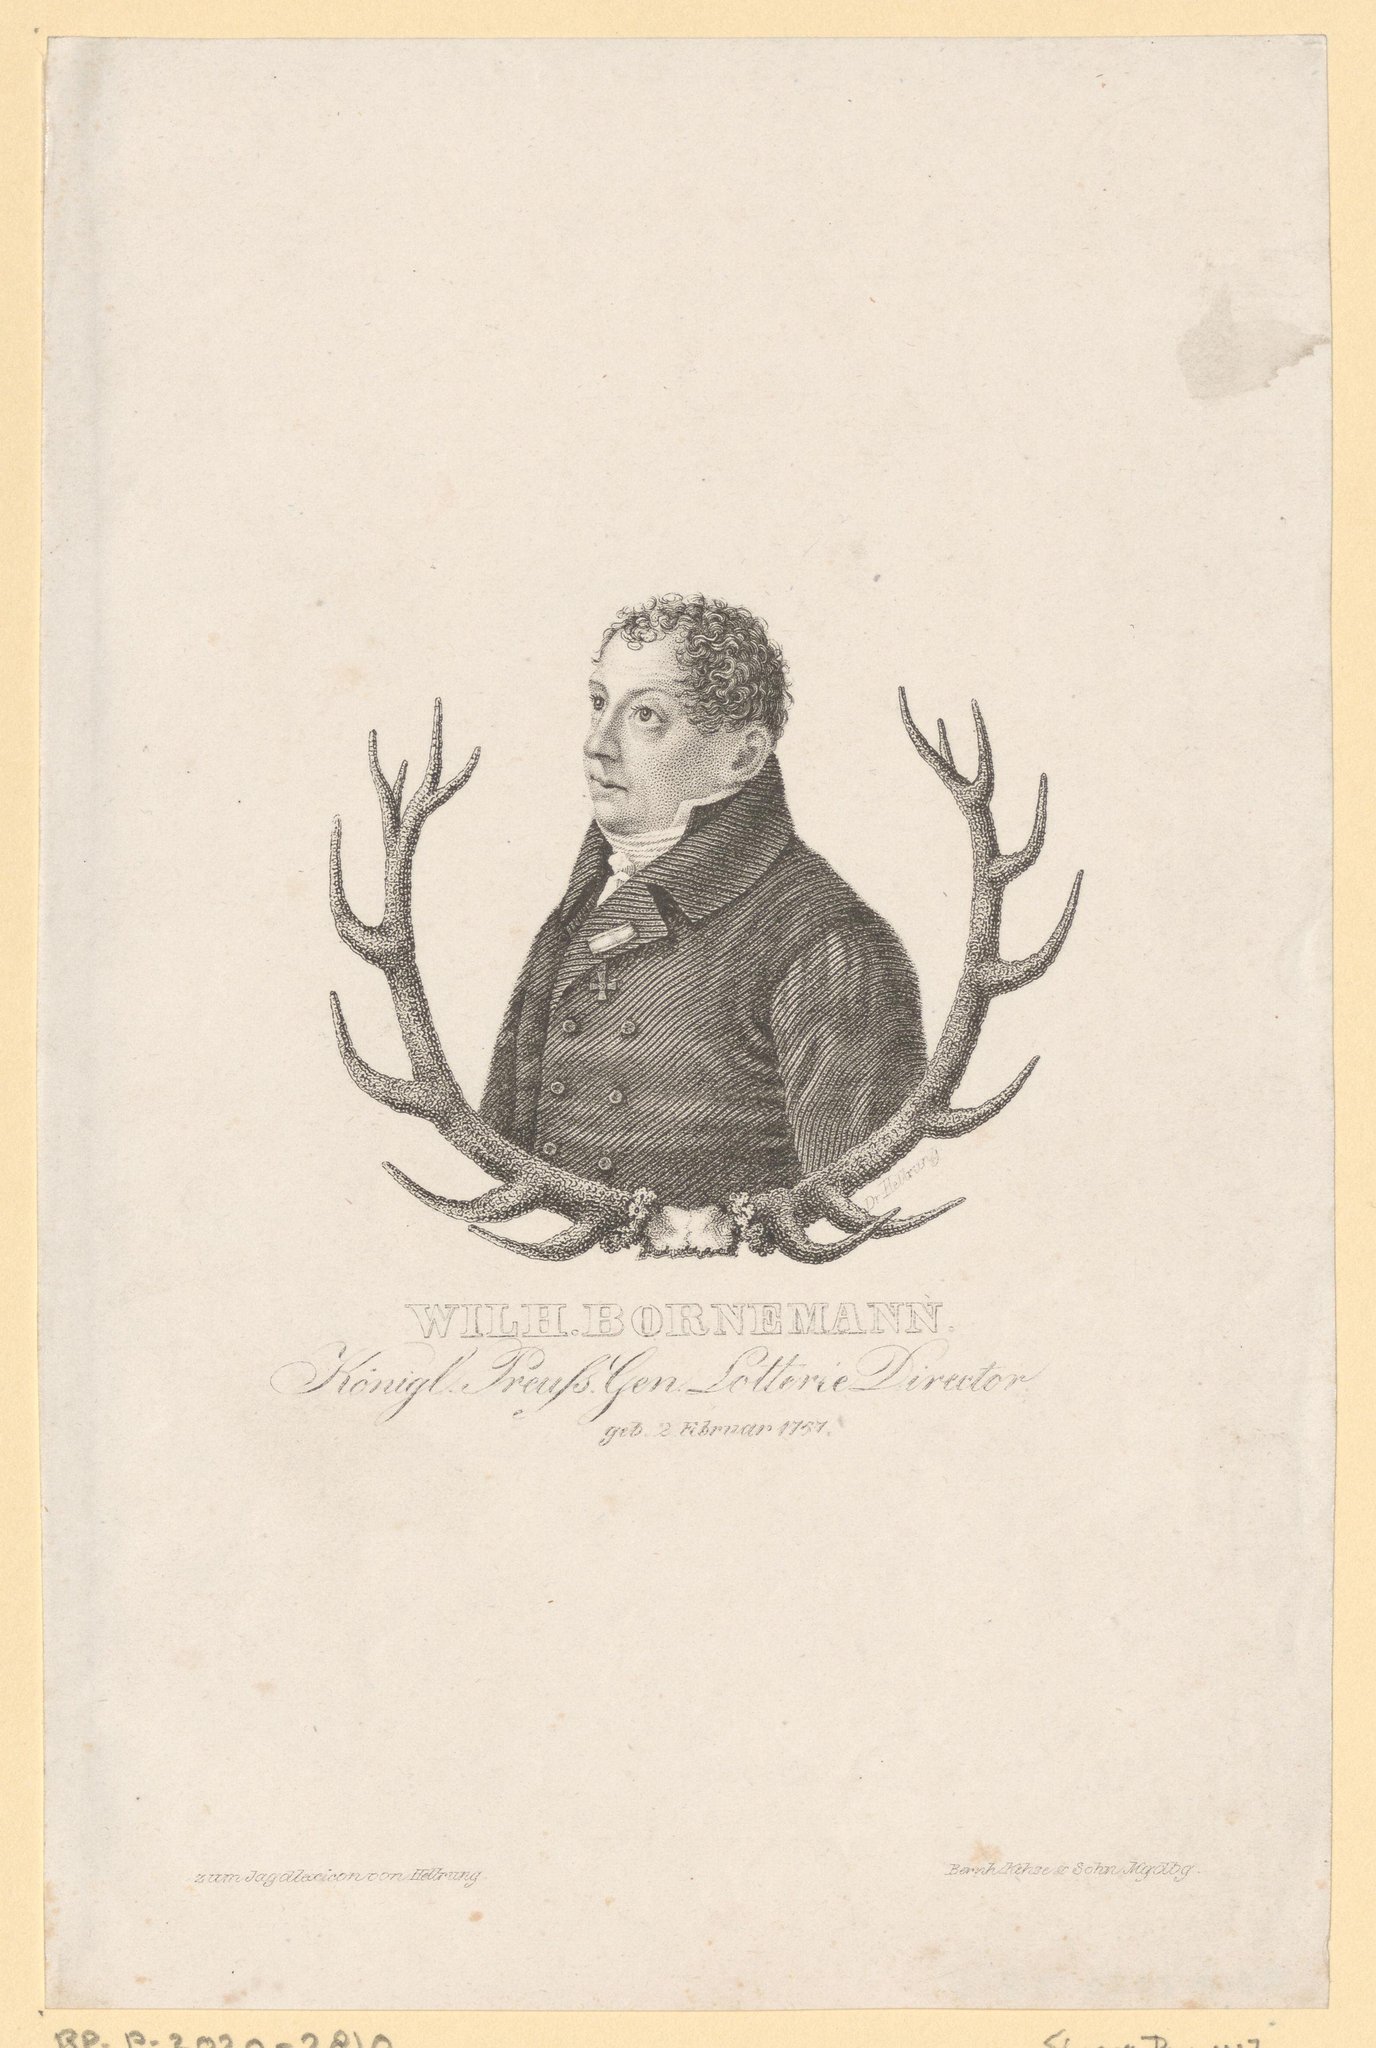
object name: book illustration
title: Portret van Wilhelm Bornemann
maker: carl ludwig hellrung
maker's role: draughtsman, print maker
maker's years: 1794-1851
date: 1839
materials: paper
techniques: lithograph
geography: magdeburg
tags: historical persons, hunting trophies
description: Prent waarschijnlijk uit: Hellrung, Carl Ludwig. Conversations-lexicon fur Jäger und Jagdfreunde. Leipzig: s.n., 1839.